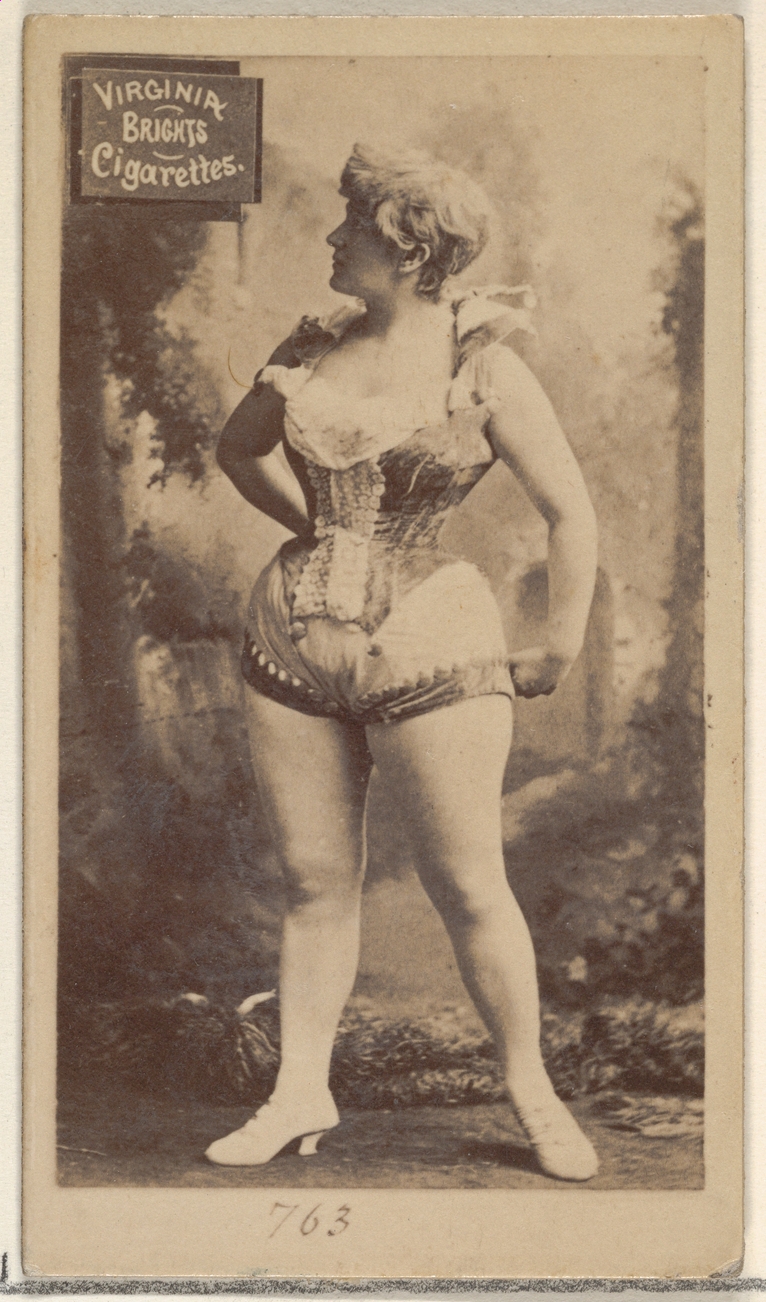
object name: photograph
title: Card 763, from the Actors and Actresses series (N45, Type 2) for Virginia Brights Cigarettes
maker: allen & ginter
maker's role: publisher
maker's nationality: american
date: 1888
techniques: albumen silver print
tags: portraits,women,actresses